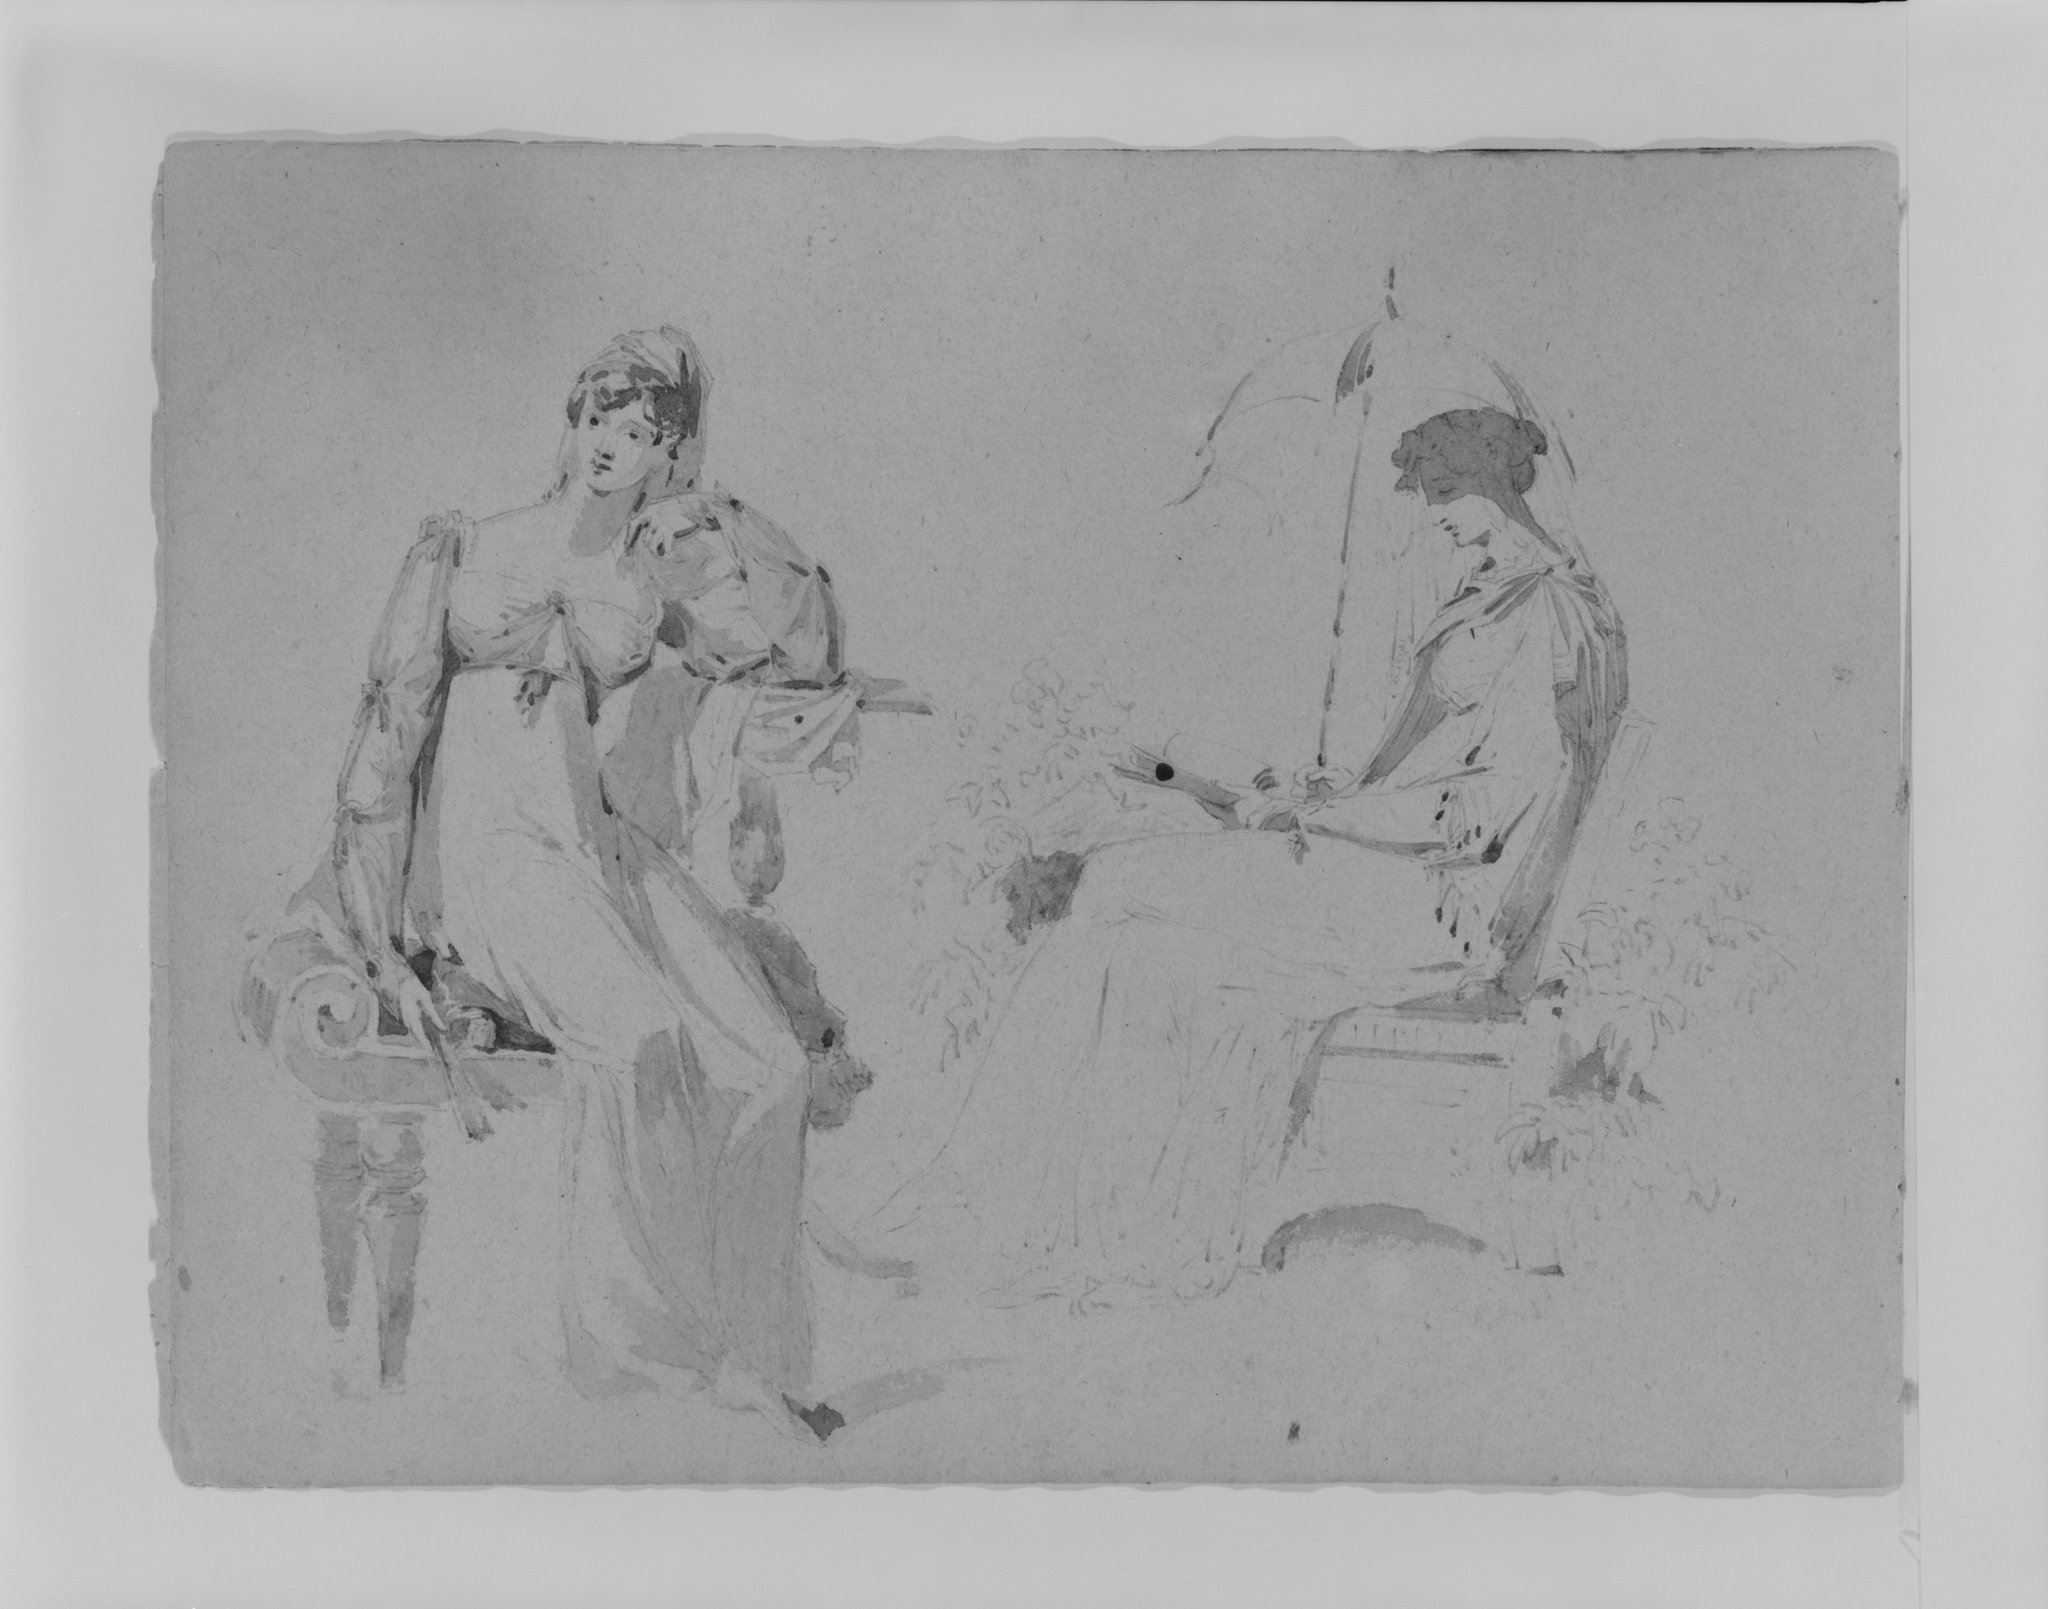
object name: drawing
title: (From Sketchbook)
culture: american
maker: thomas sully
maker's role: artist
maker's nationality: american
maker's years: 1783-1872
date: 1810-1820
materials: ink, paper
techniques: wash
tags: women